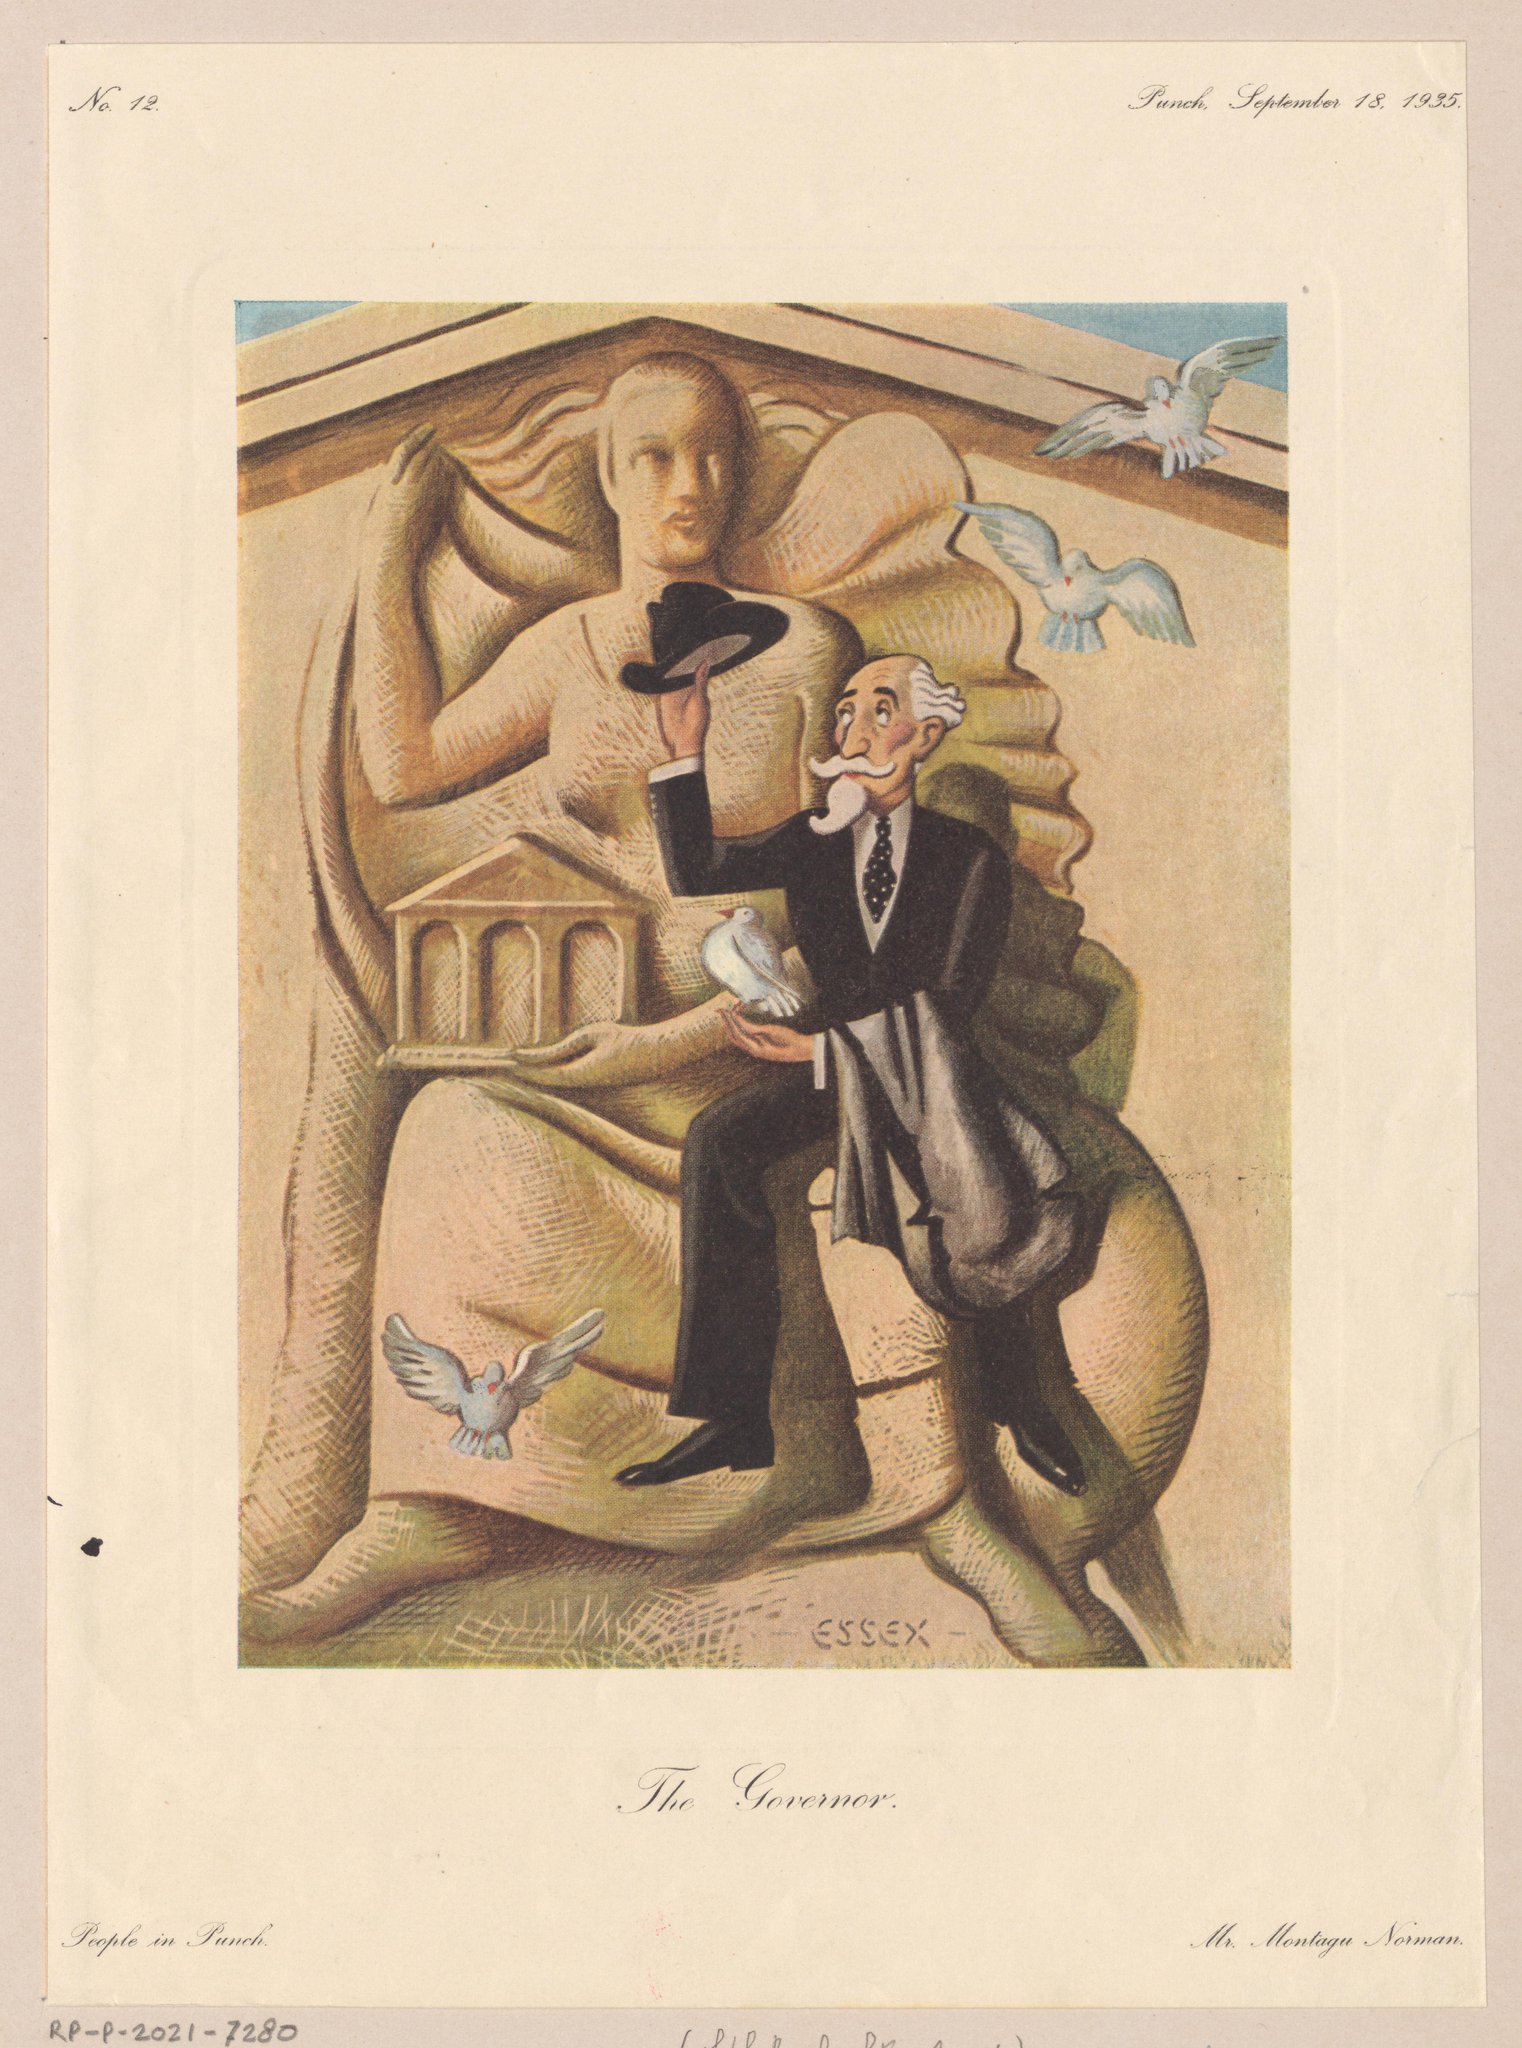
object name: photomechanical print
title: Karikatuur van Montagu Norman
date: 1935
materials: paper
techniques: color autotype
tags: historical persons, governor, etc. of province, political caricatures and satires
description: Montagu Norman zittend op de knie van de vrouwfiguur in reliëf op het timpaan van het gebouw van de Bank of England. Rondom hem vliegen enkele duiven.